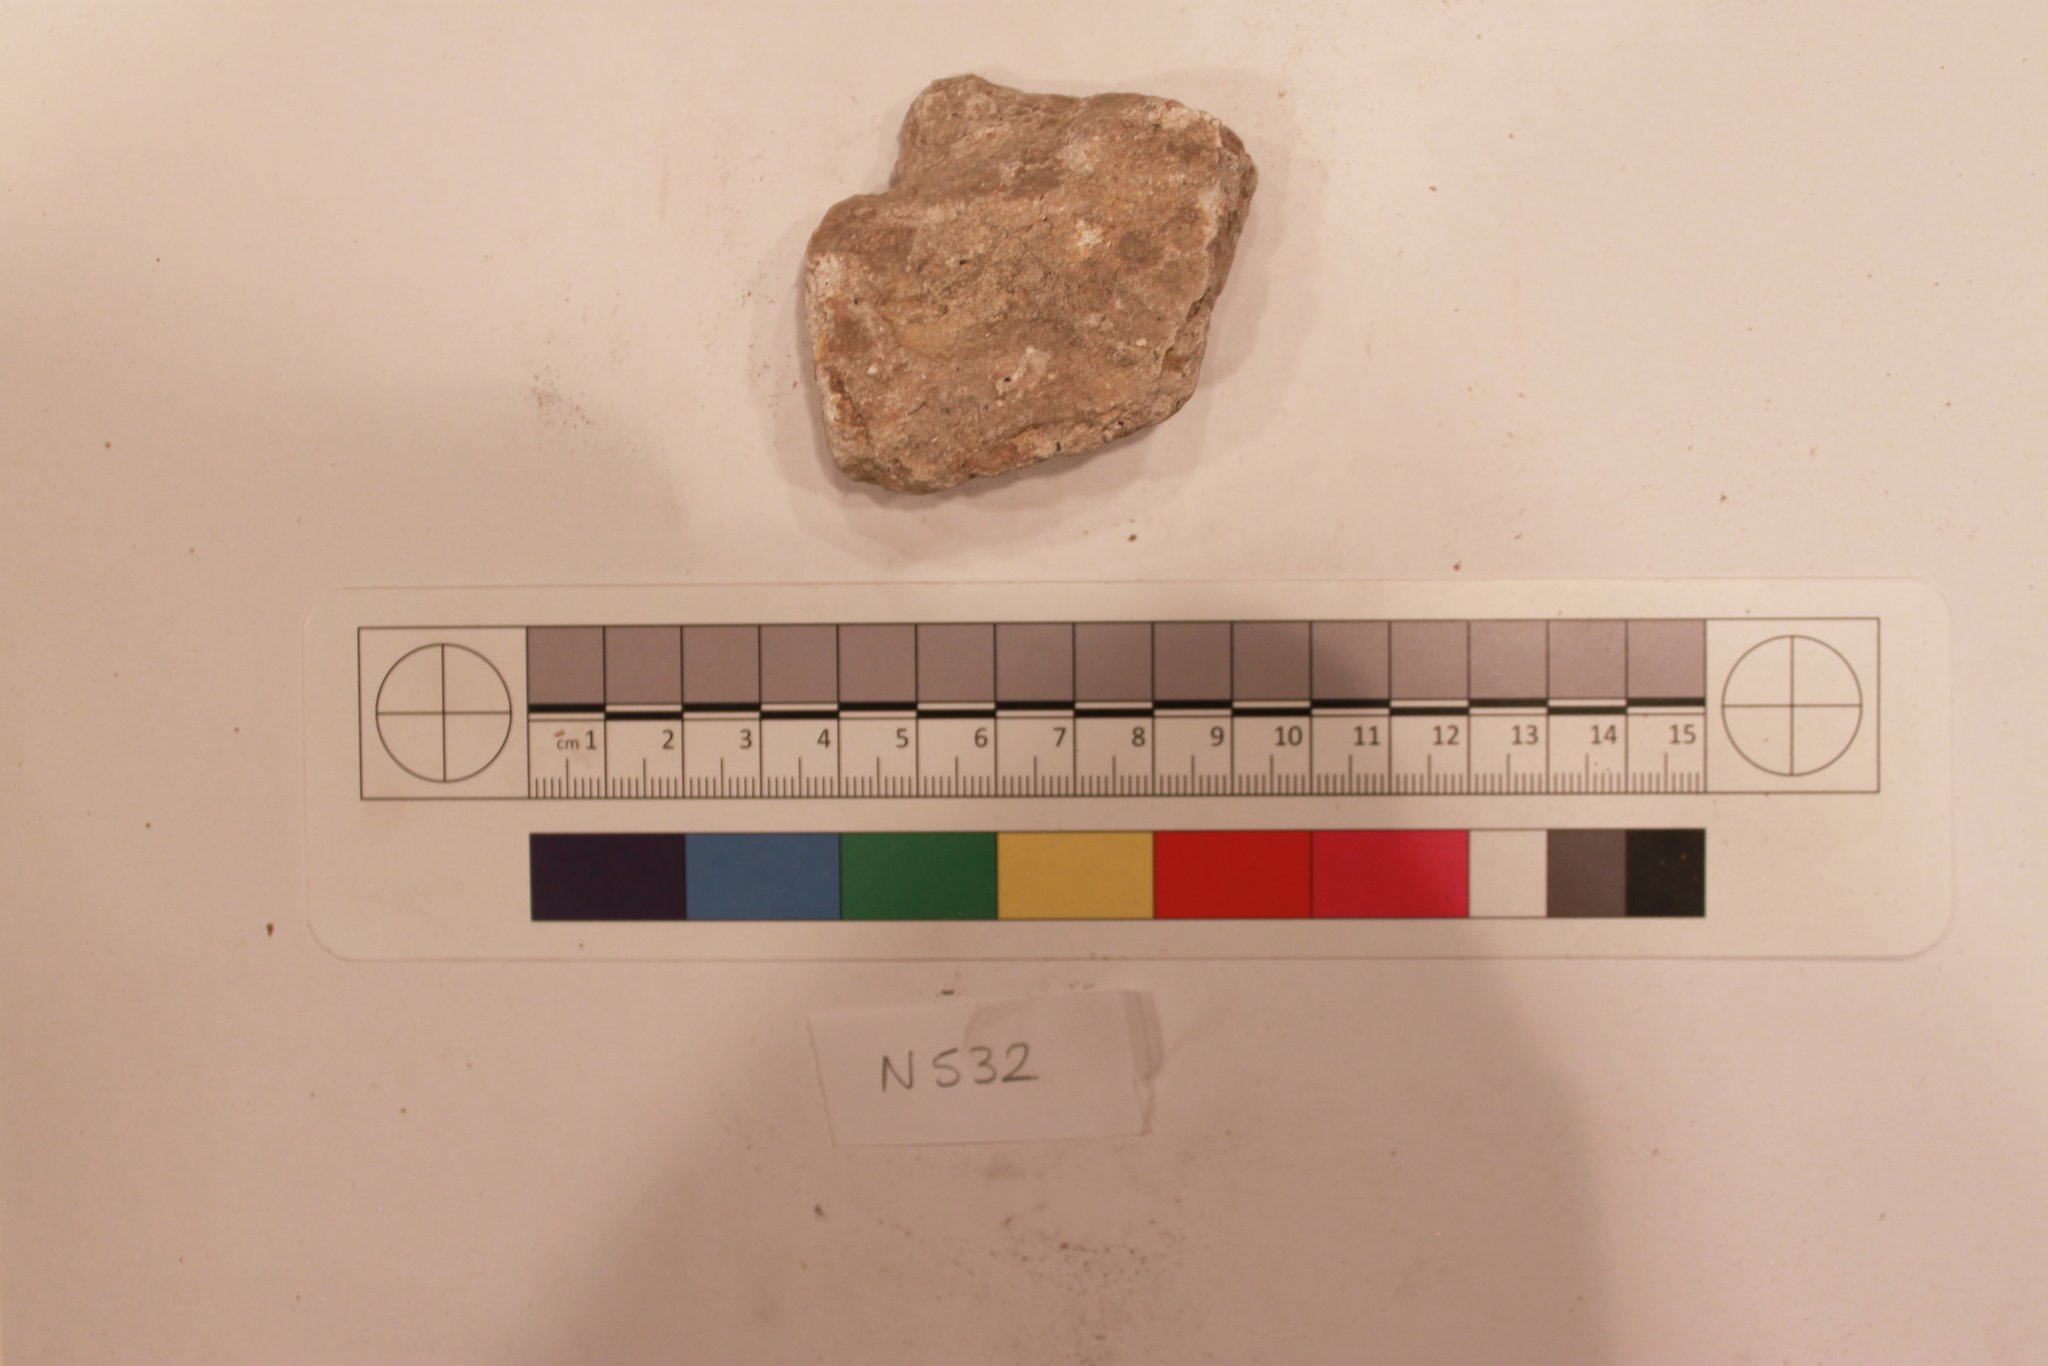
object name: fragment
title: Stucco Fragment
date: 701-1200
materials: plaster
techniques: carving, painting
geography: iran